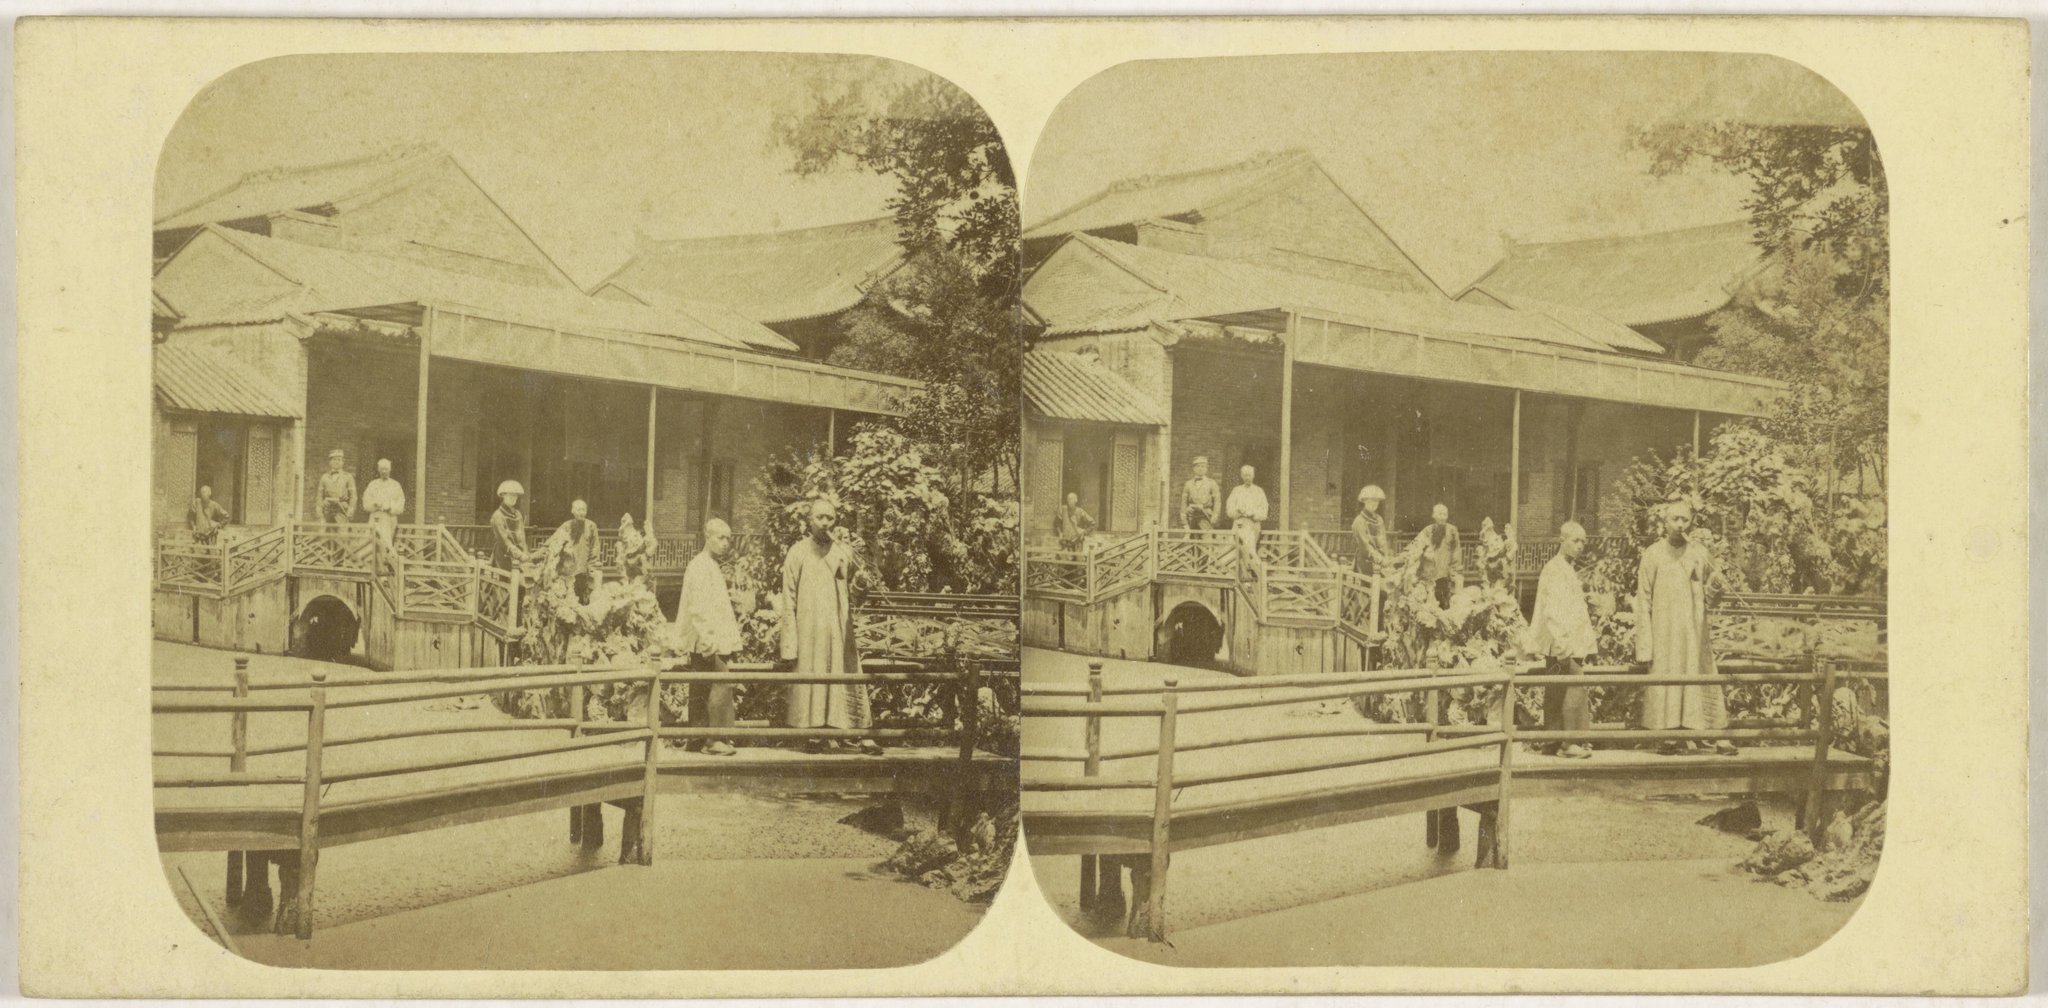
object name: stereograph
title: View in the Yamun of the Allied Commissioners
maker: pierre joseph rossier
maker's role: fotograaf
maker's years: 1829-1889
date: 1858-1862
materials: cardboard, paper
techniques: albumen print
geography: guangzhou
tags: office (~ administration)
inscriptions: number: ‘81’, inscription: ‘Ent. Sta. Hall Deposé’